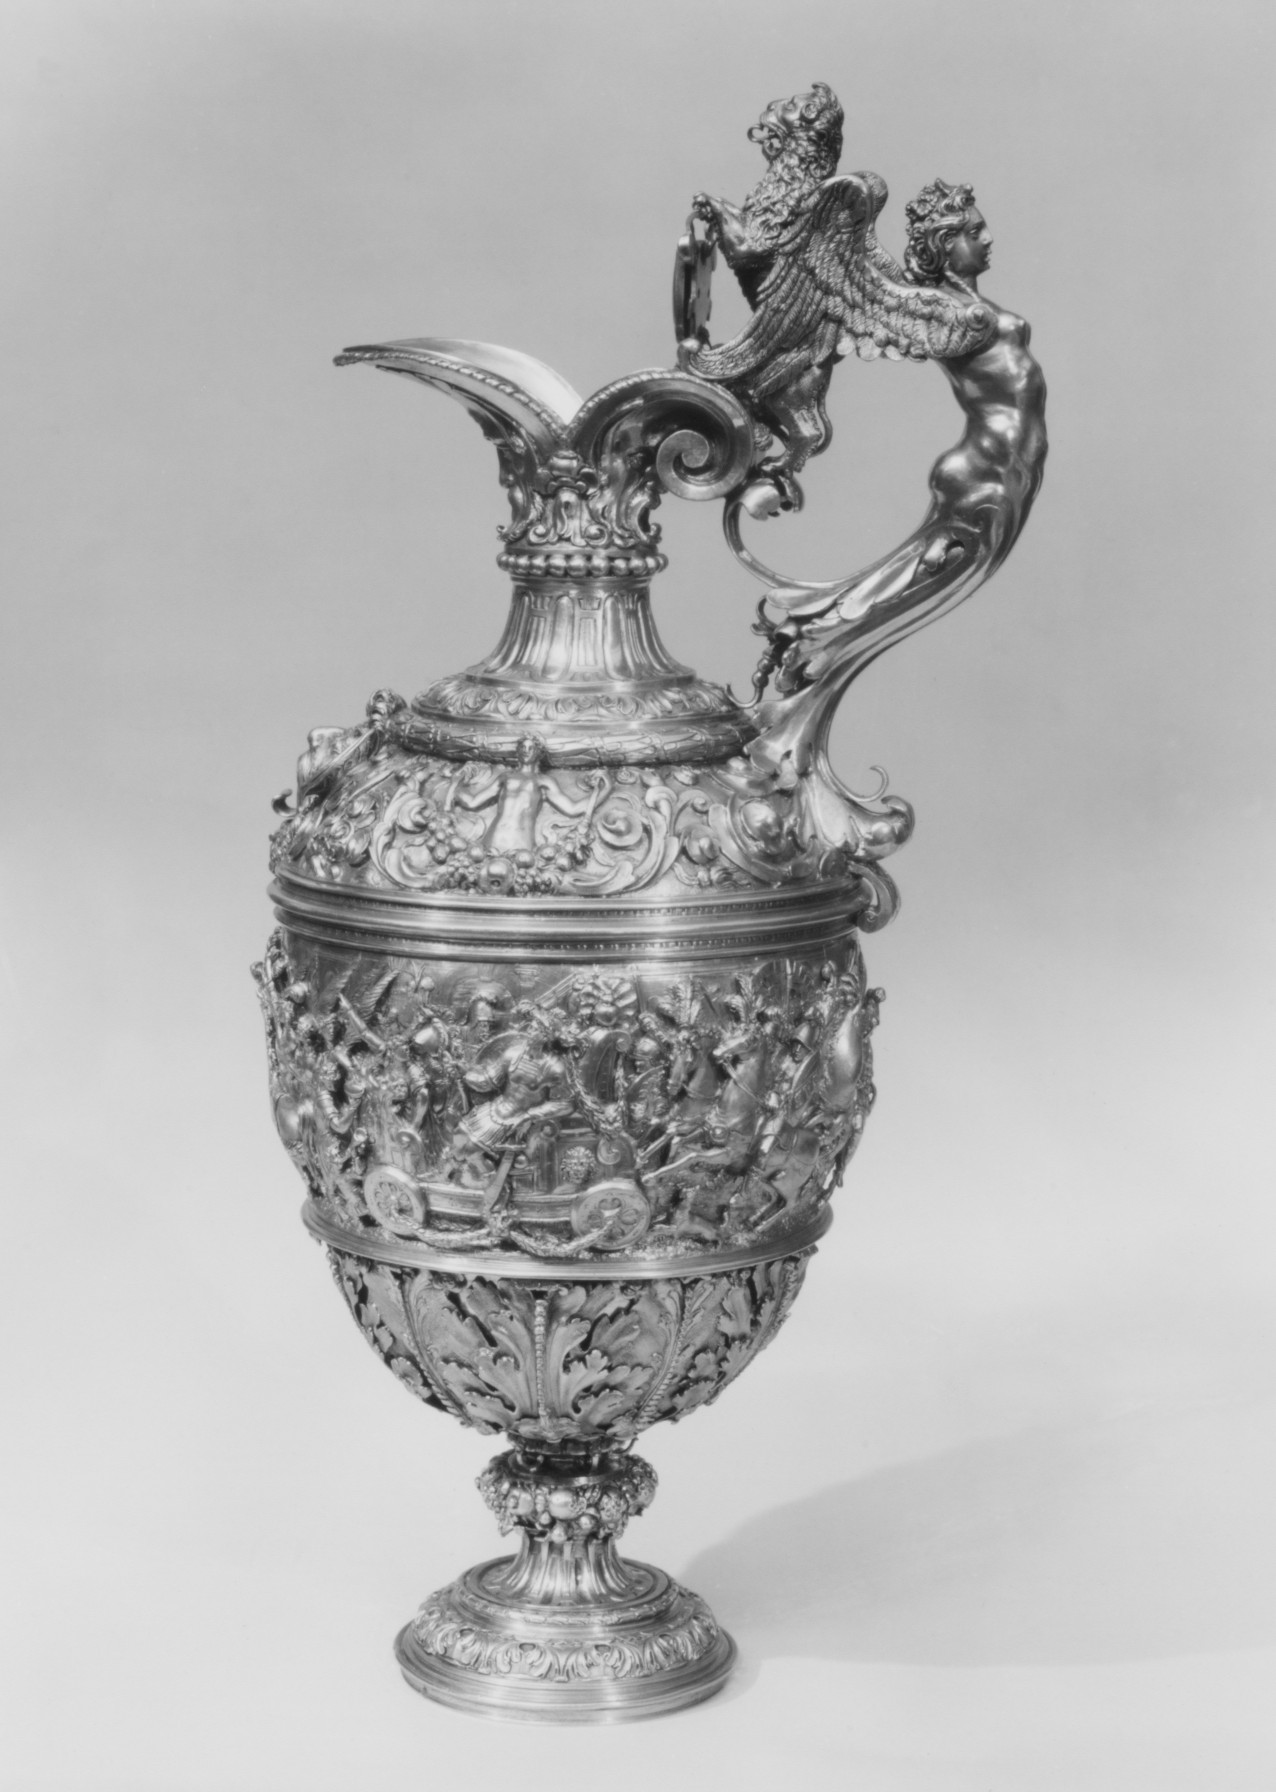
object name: ewer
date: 1600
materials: enamel, silver gilt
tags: men,horses